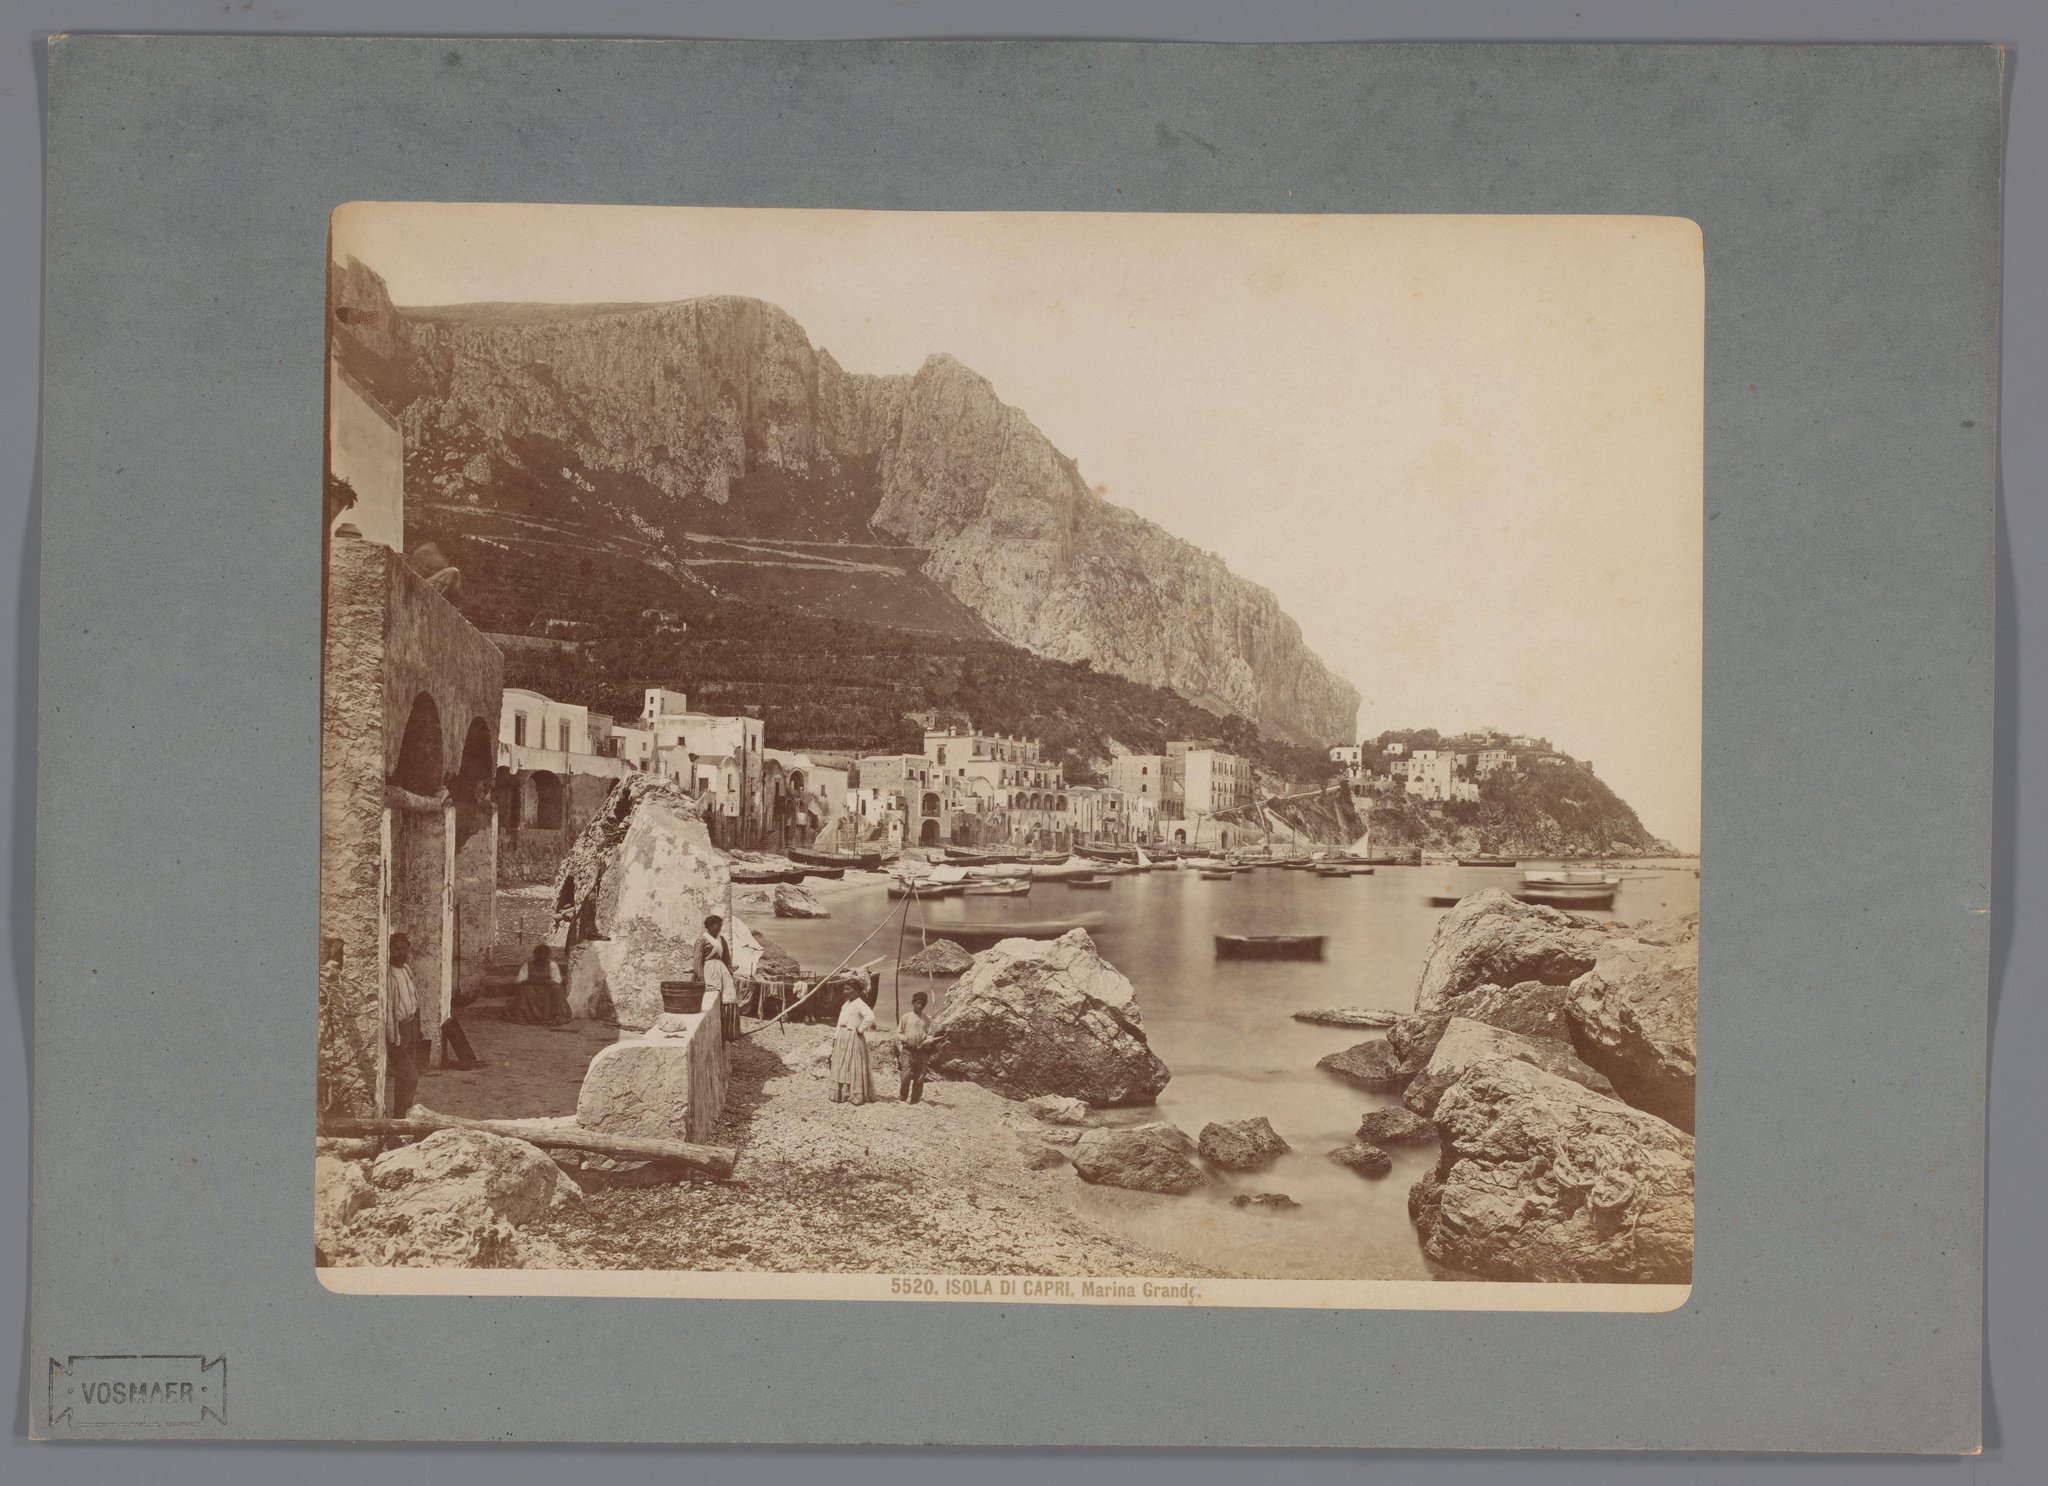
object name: photograph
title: Isola di Capri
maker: giacomo brogi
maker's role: fotograaf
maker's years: 1822-1881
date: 1864-1881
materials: cardboard, paper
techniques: albumen print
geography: capri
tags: harbour, island, capri, isola di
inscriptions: inscription: ‘doubl’, number: ‘5520.’, collector's mark: ‘VOSMAER’